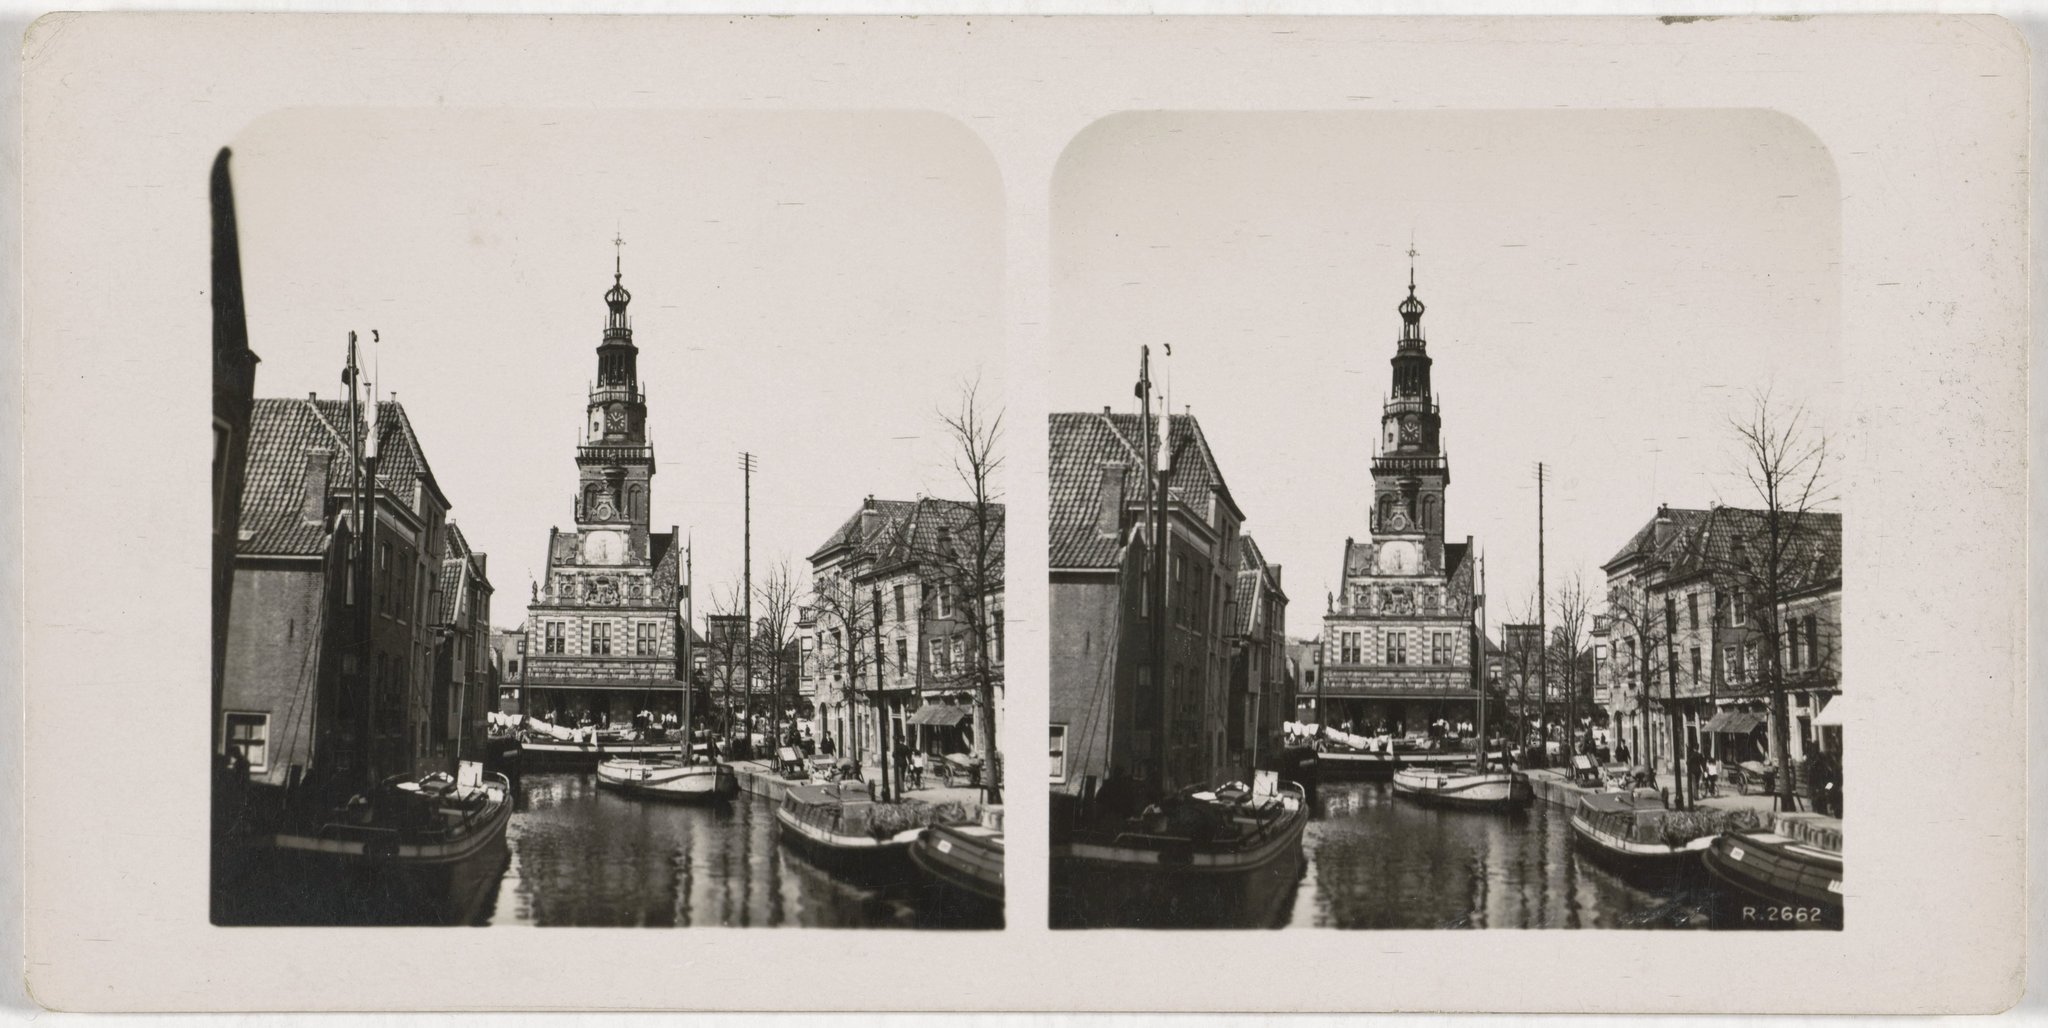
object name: stereograph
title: Gezicht op de Waag in Alkmaar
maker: Anonymous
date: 1900-1935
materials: photographic support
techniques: gelatin silver print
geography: alkmaar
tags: city-view in general; 'veduta', weigh-house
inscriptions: number: ‘No. 2662.’, number: ‘R. 2662’